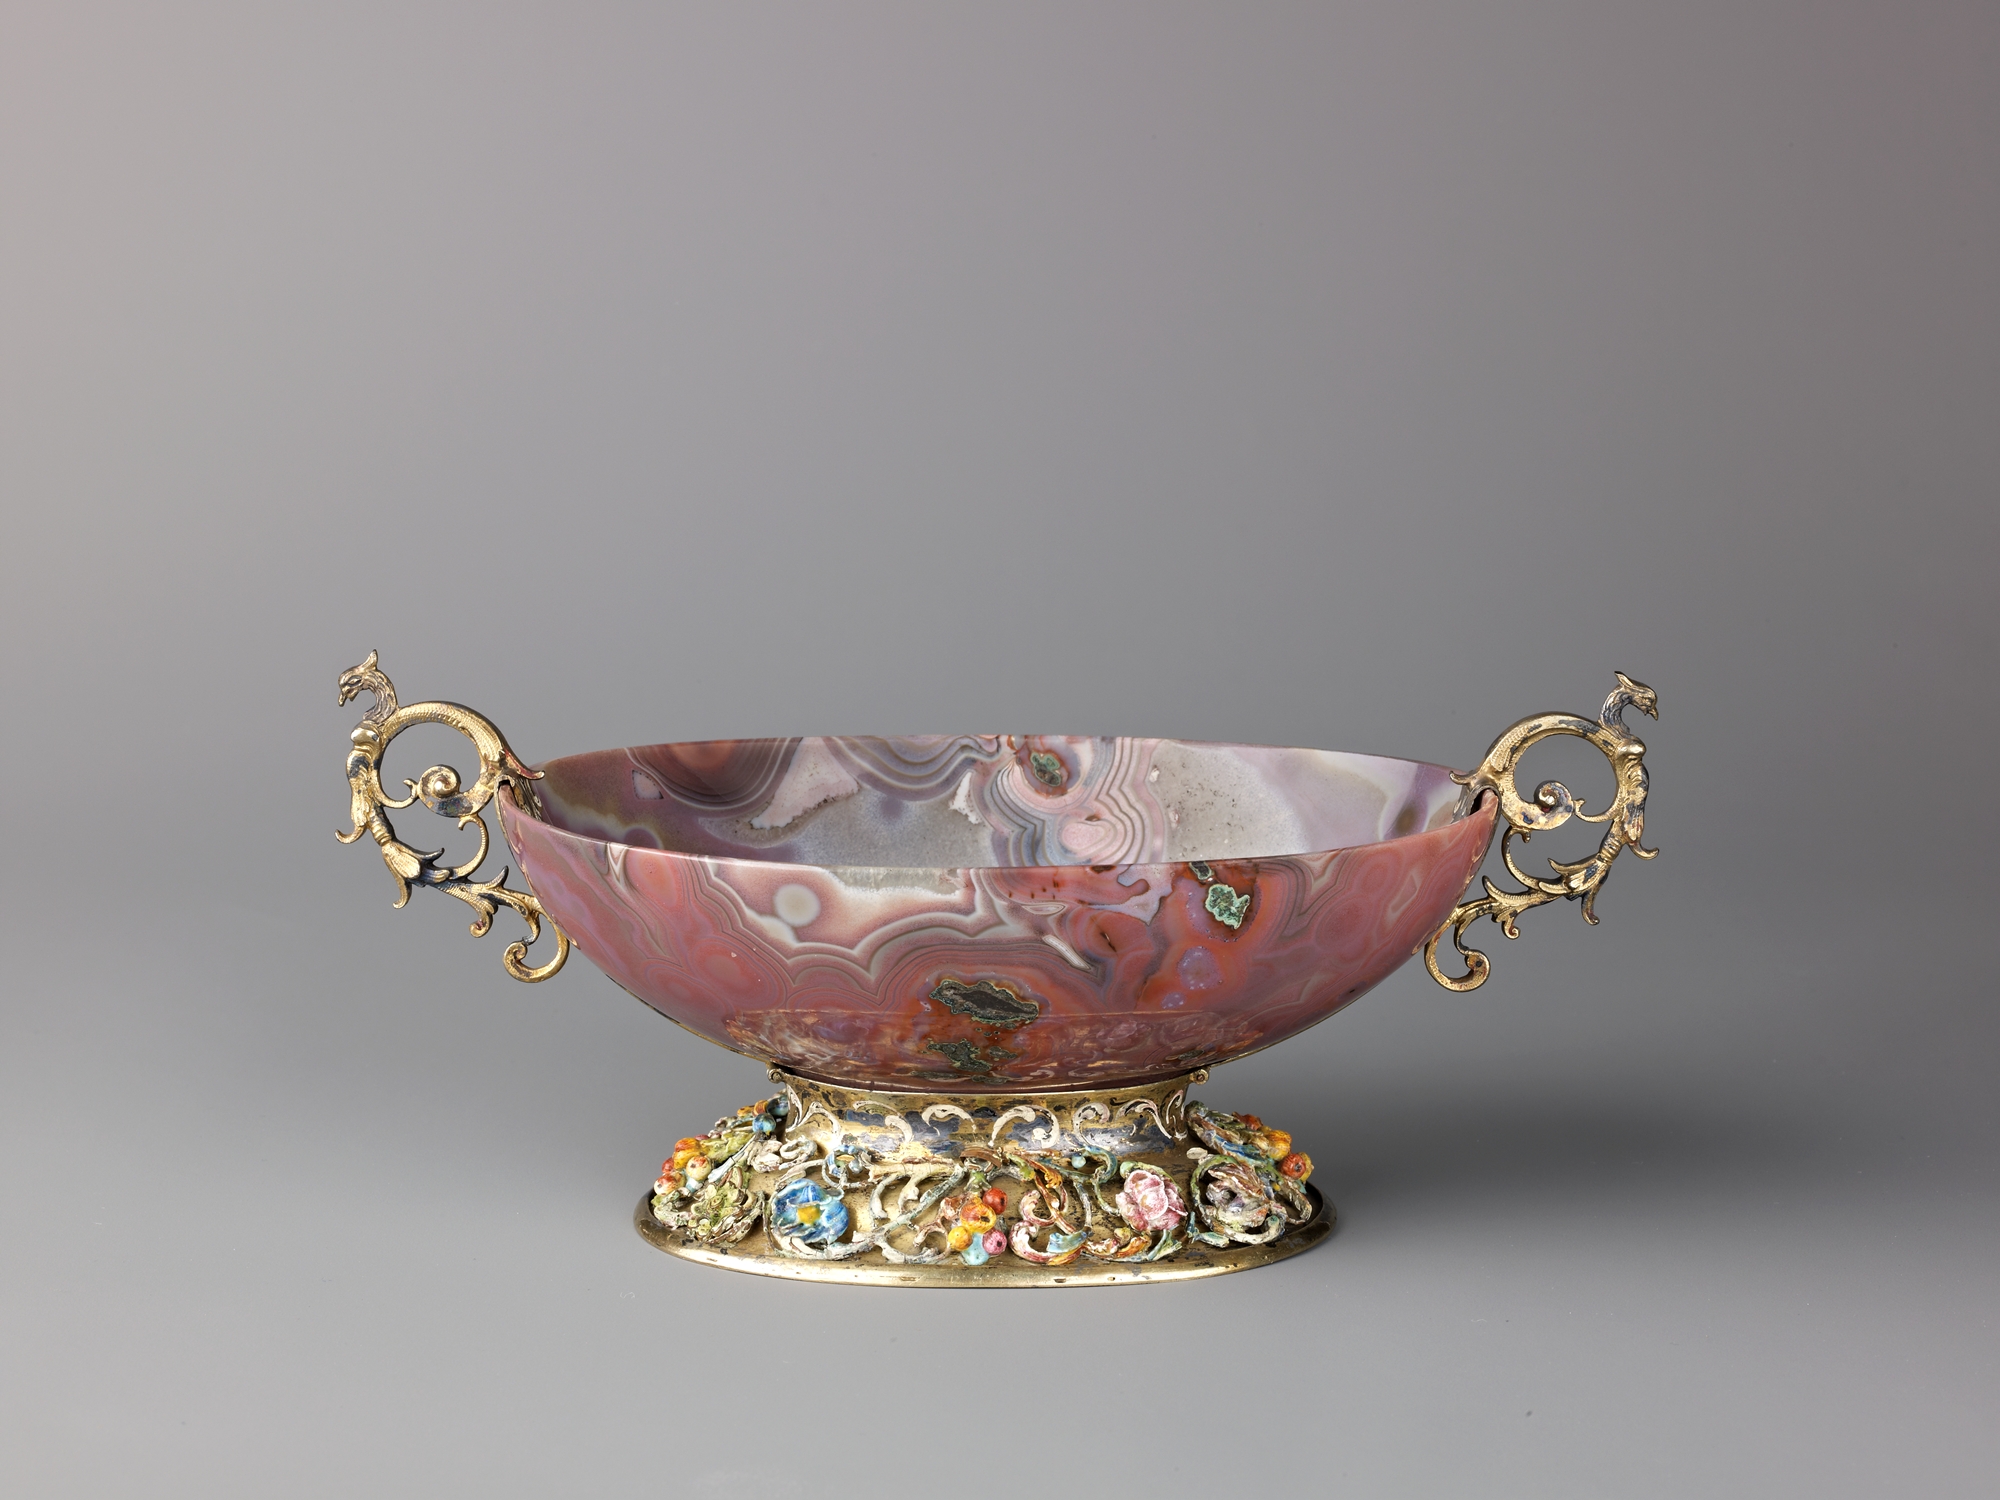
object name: bowl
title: Bowl with Handles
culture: german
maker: marx merzenbach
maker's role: artist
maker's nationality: german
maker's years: 1642-1688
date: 1680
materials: enamel, jasper, silver gilt